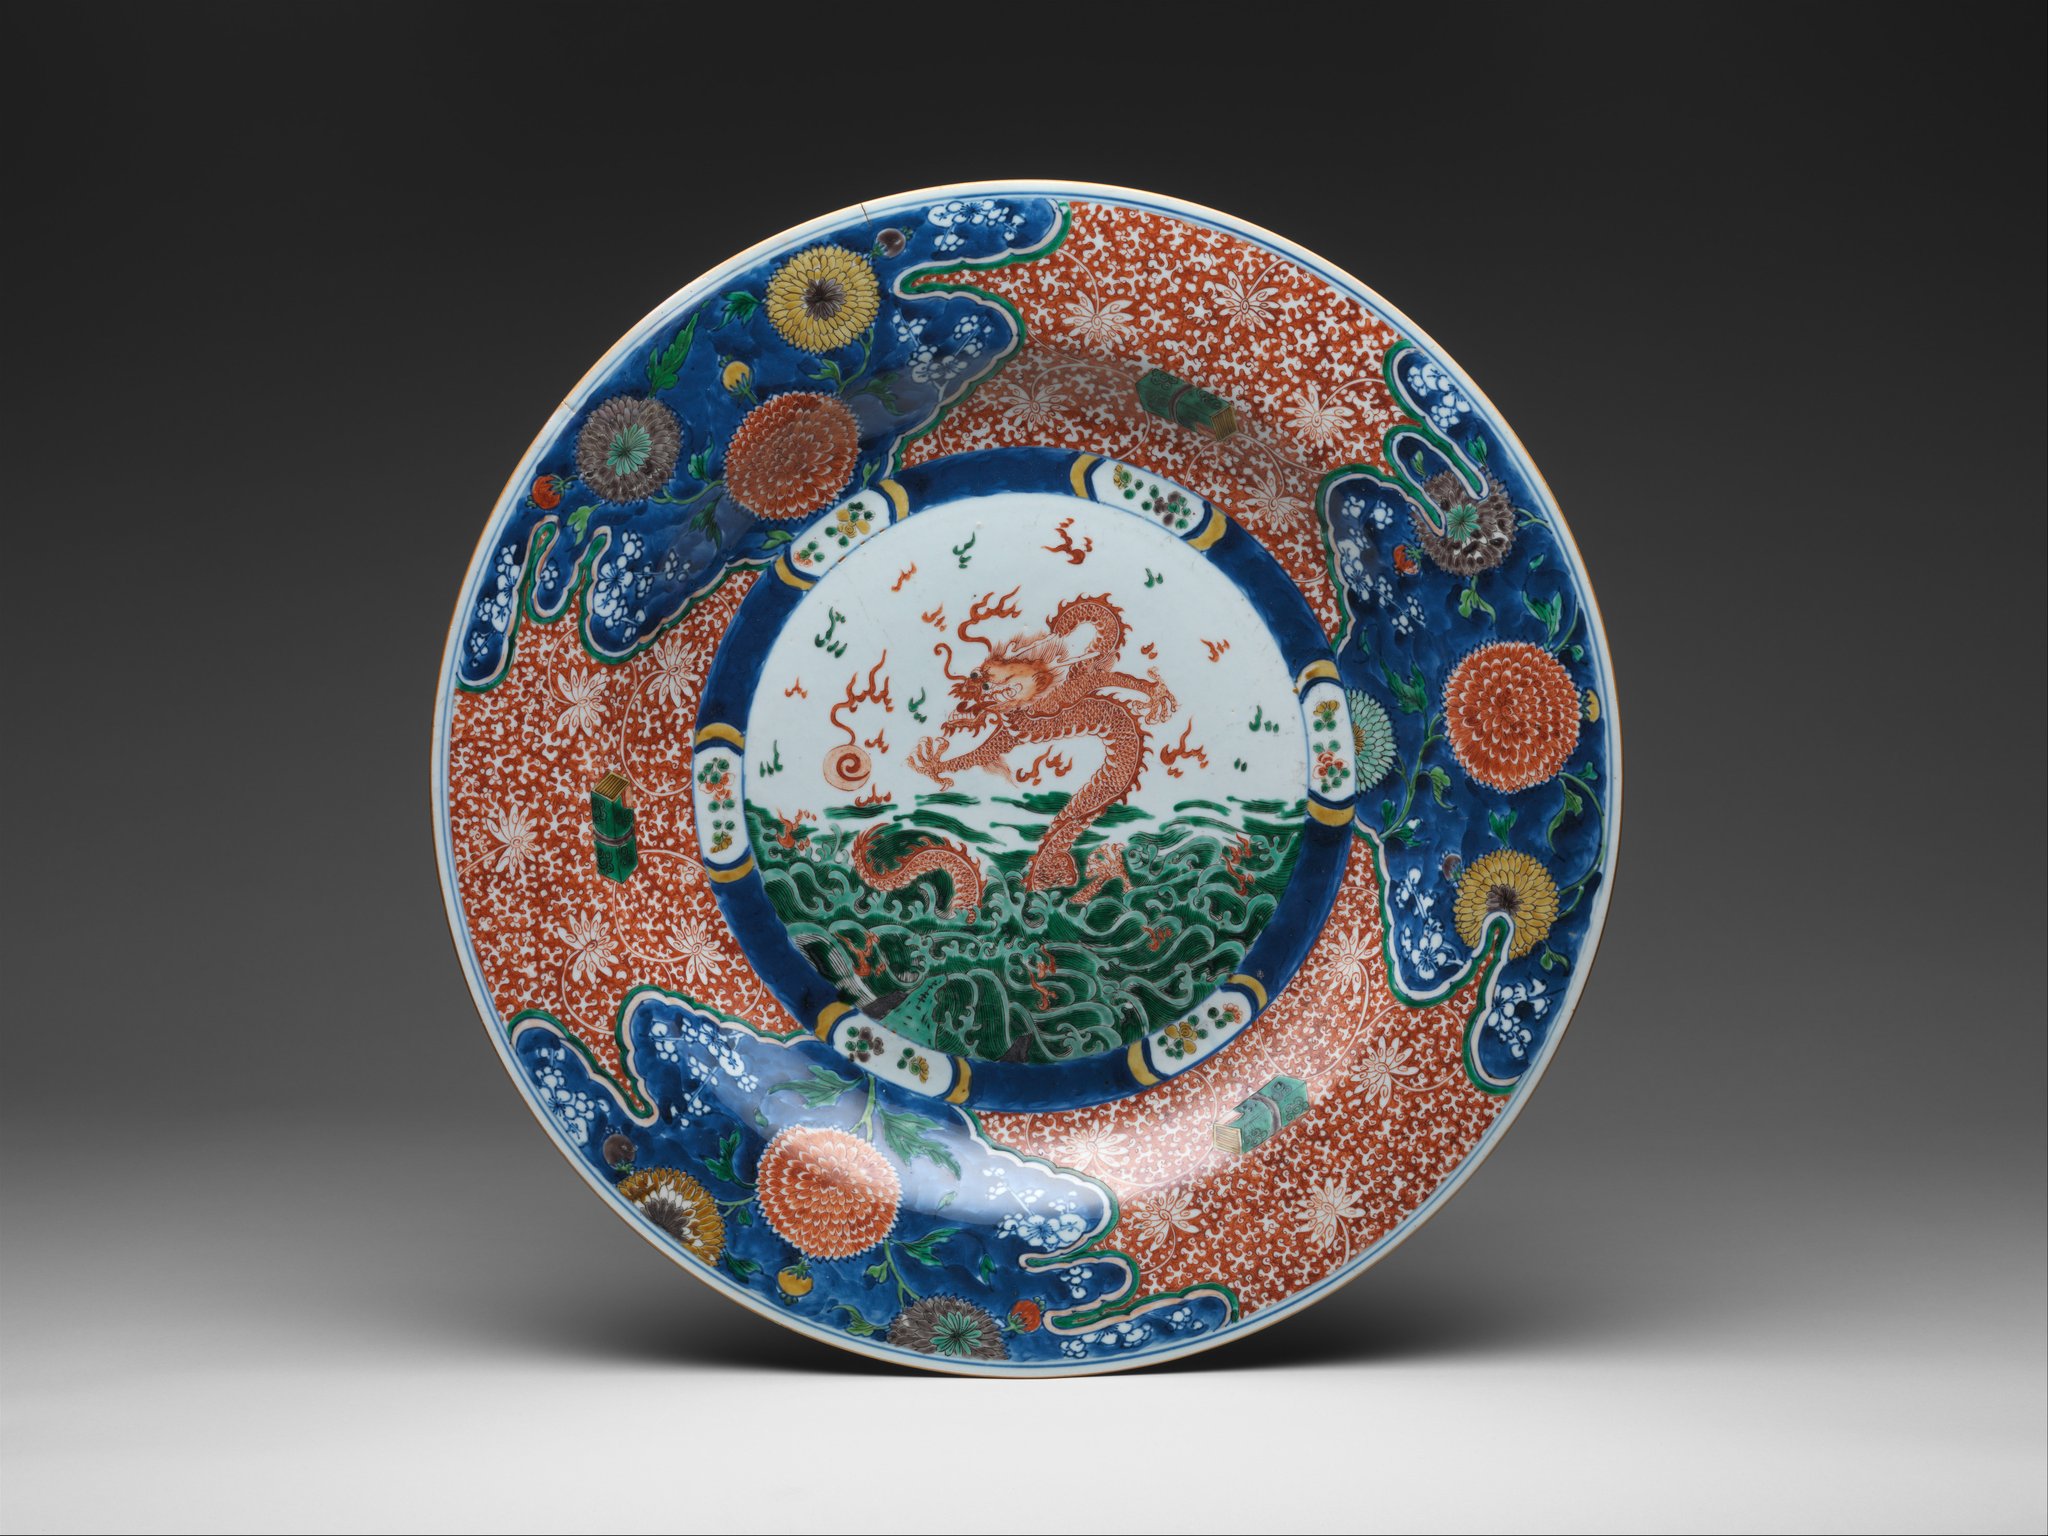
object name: plate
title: Plate with Dragon and Waves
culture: chinese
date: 1701-1750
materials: enamel, glaze, porcelain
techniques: gilding, painting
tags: dragons,waves